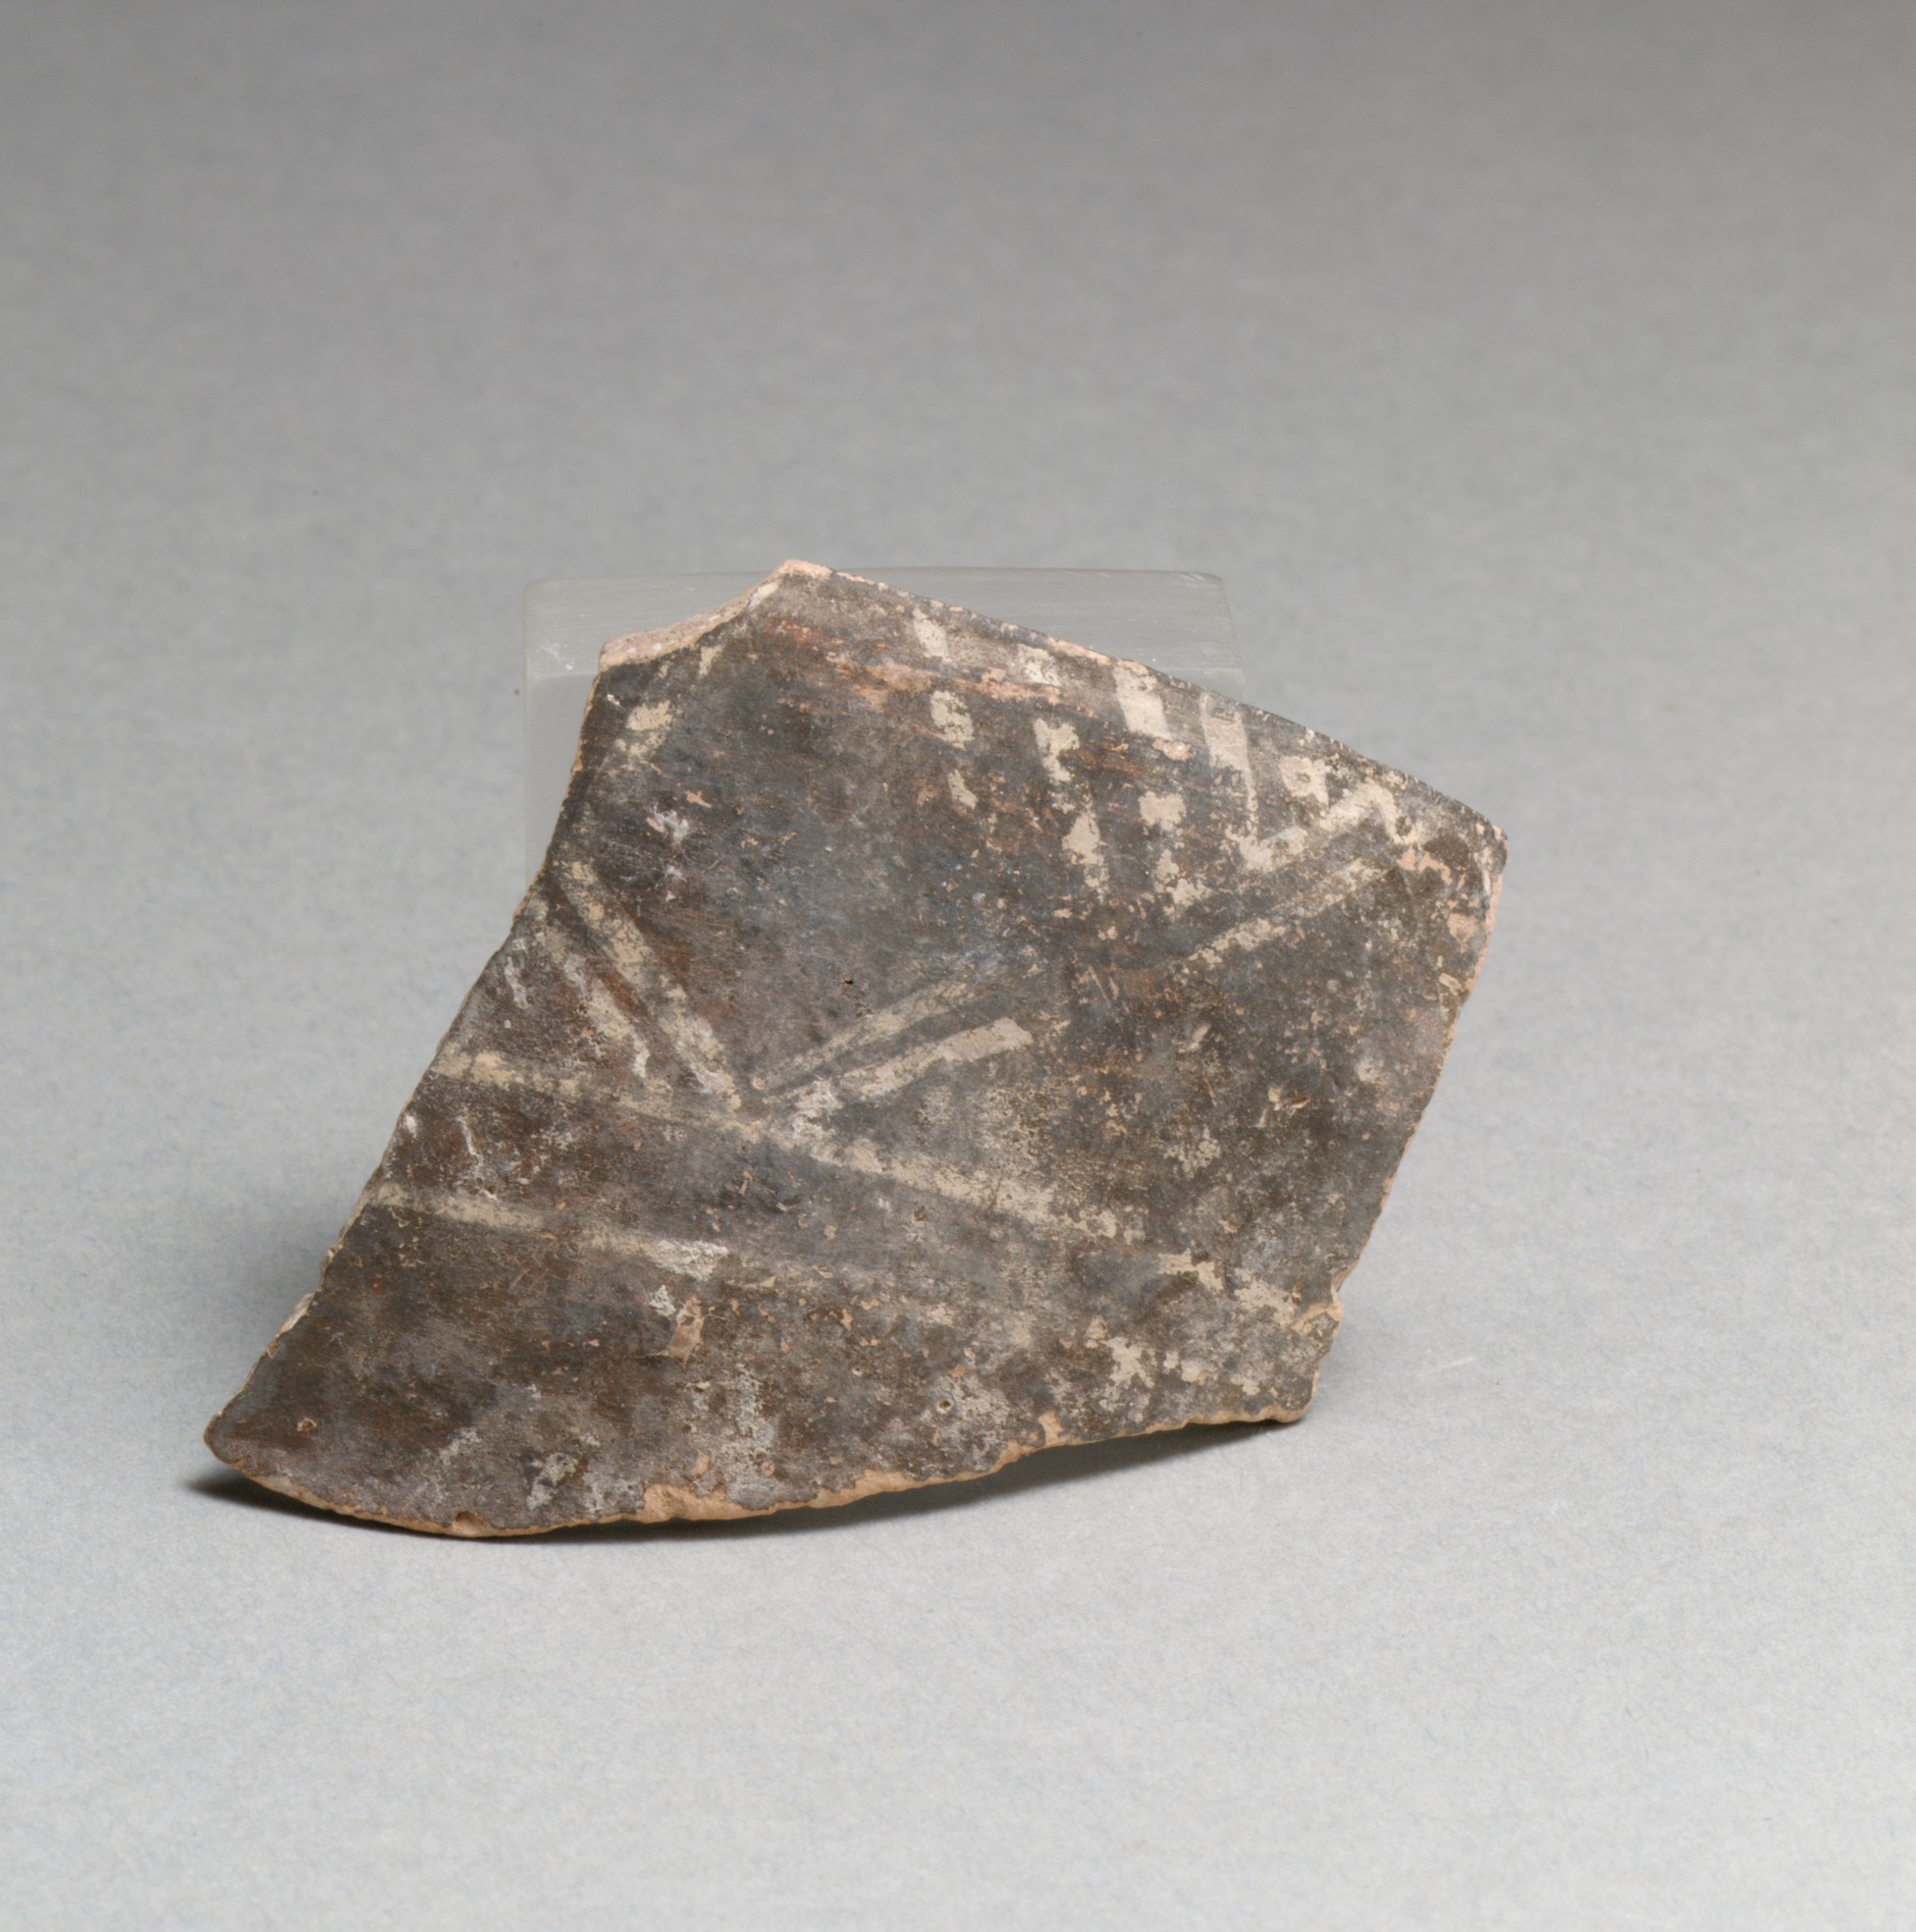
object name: vase fragment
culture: minoan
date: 2600-2000 BCE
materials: terracotta